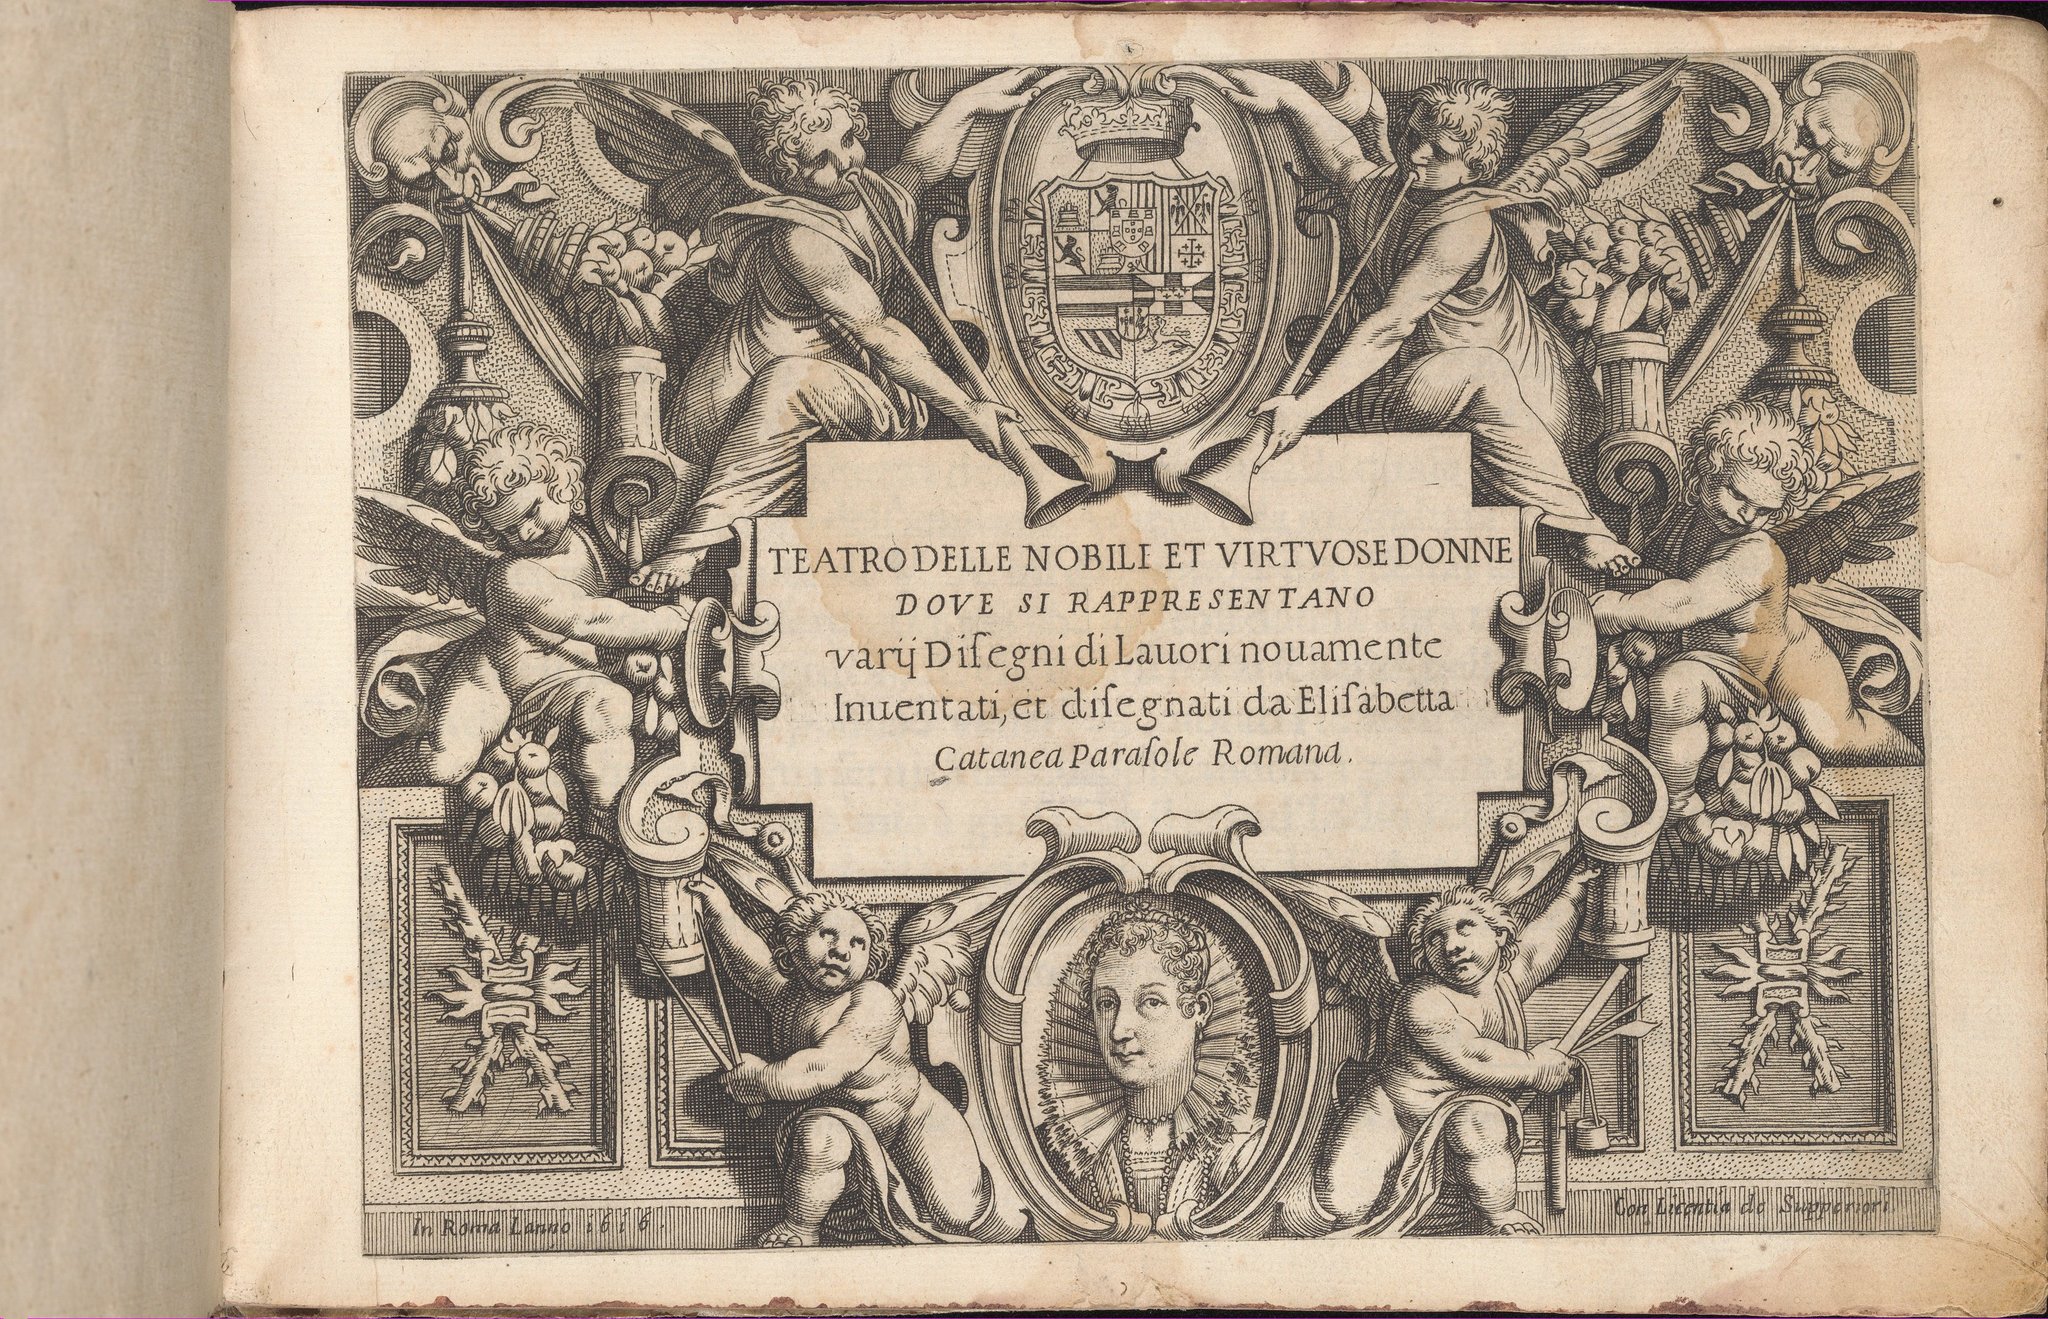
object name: book print ornament architecture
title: Teatro delle Nobili et Virtuose Donne...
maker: isabella catanea parasole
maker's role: author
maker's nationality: italian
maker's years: 1565-1625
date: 1616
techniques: engraving, woodcut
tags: portraits,women,coat of arms